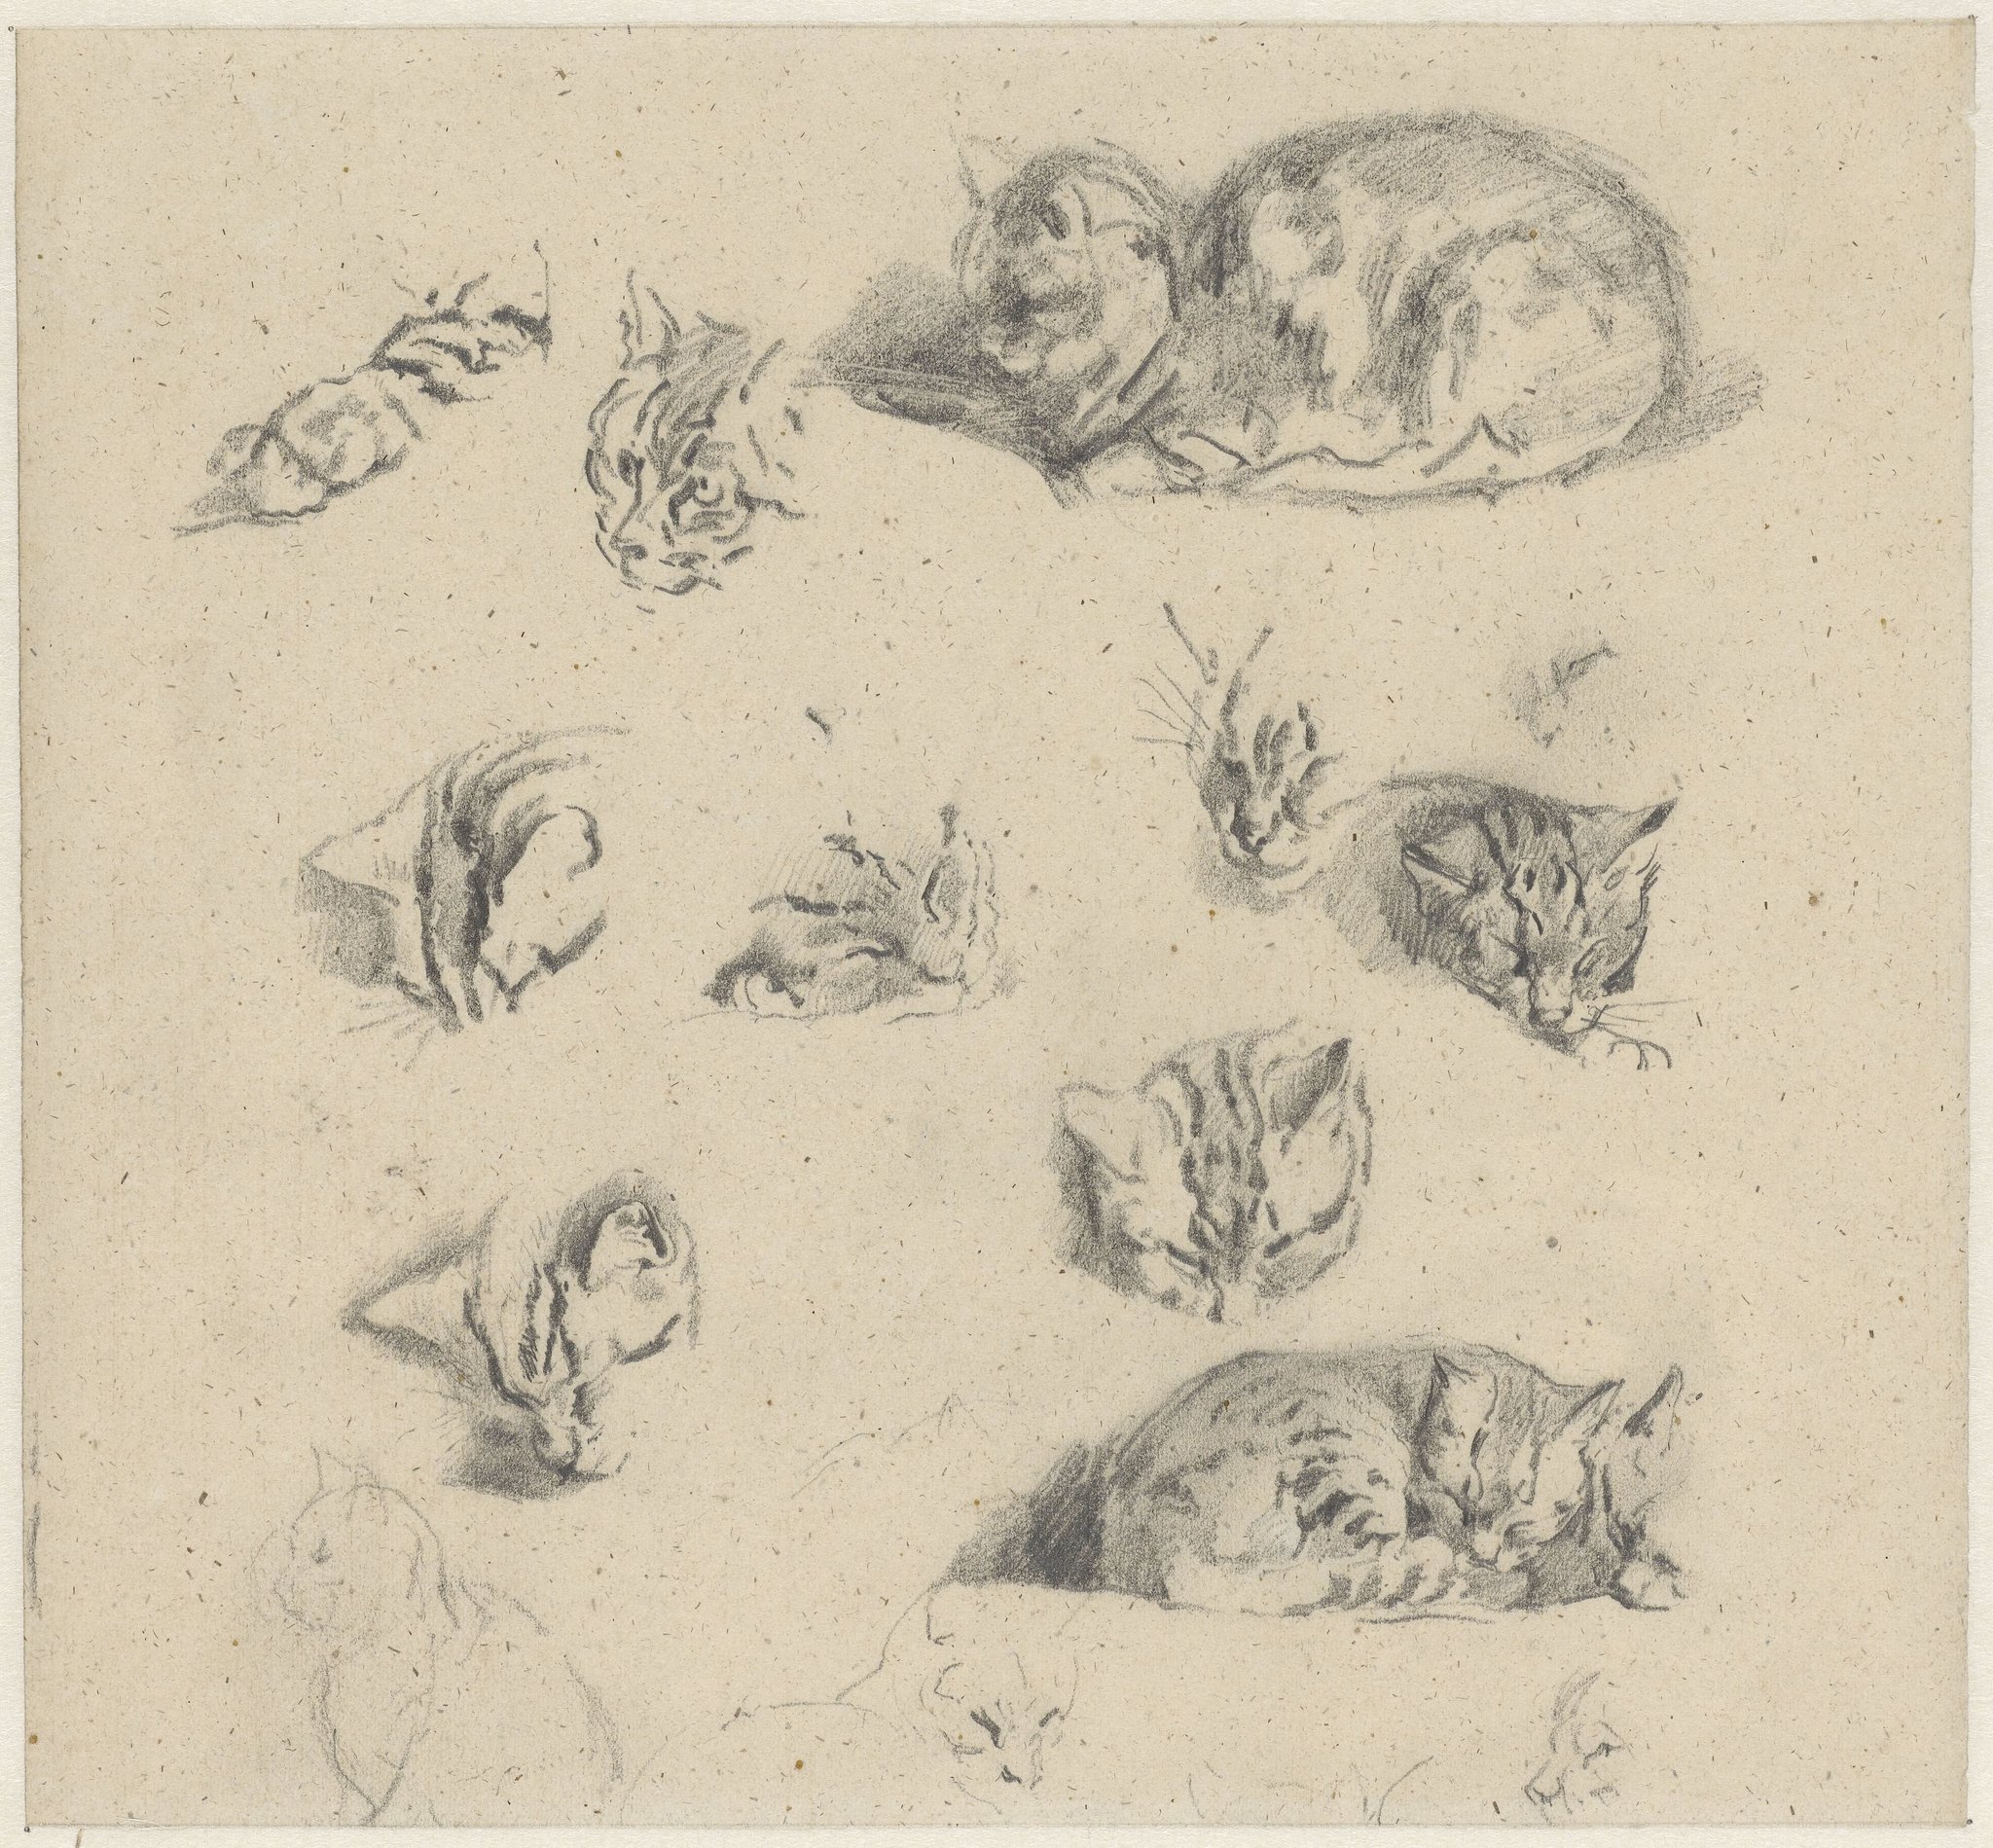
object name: drawing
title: Studies van een kat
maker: guillaume anne van der brugghen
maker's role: draughtsman, print maker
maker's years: 1812-1891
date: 1821-1891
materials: chalk, paper, pencil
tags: cat